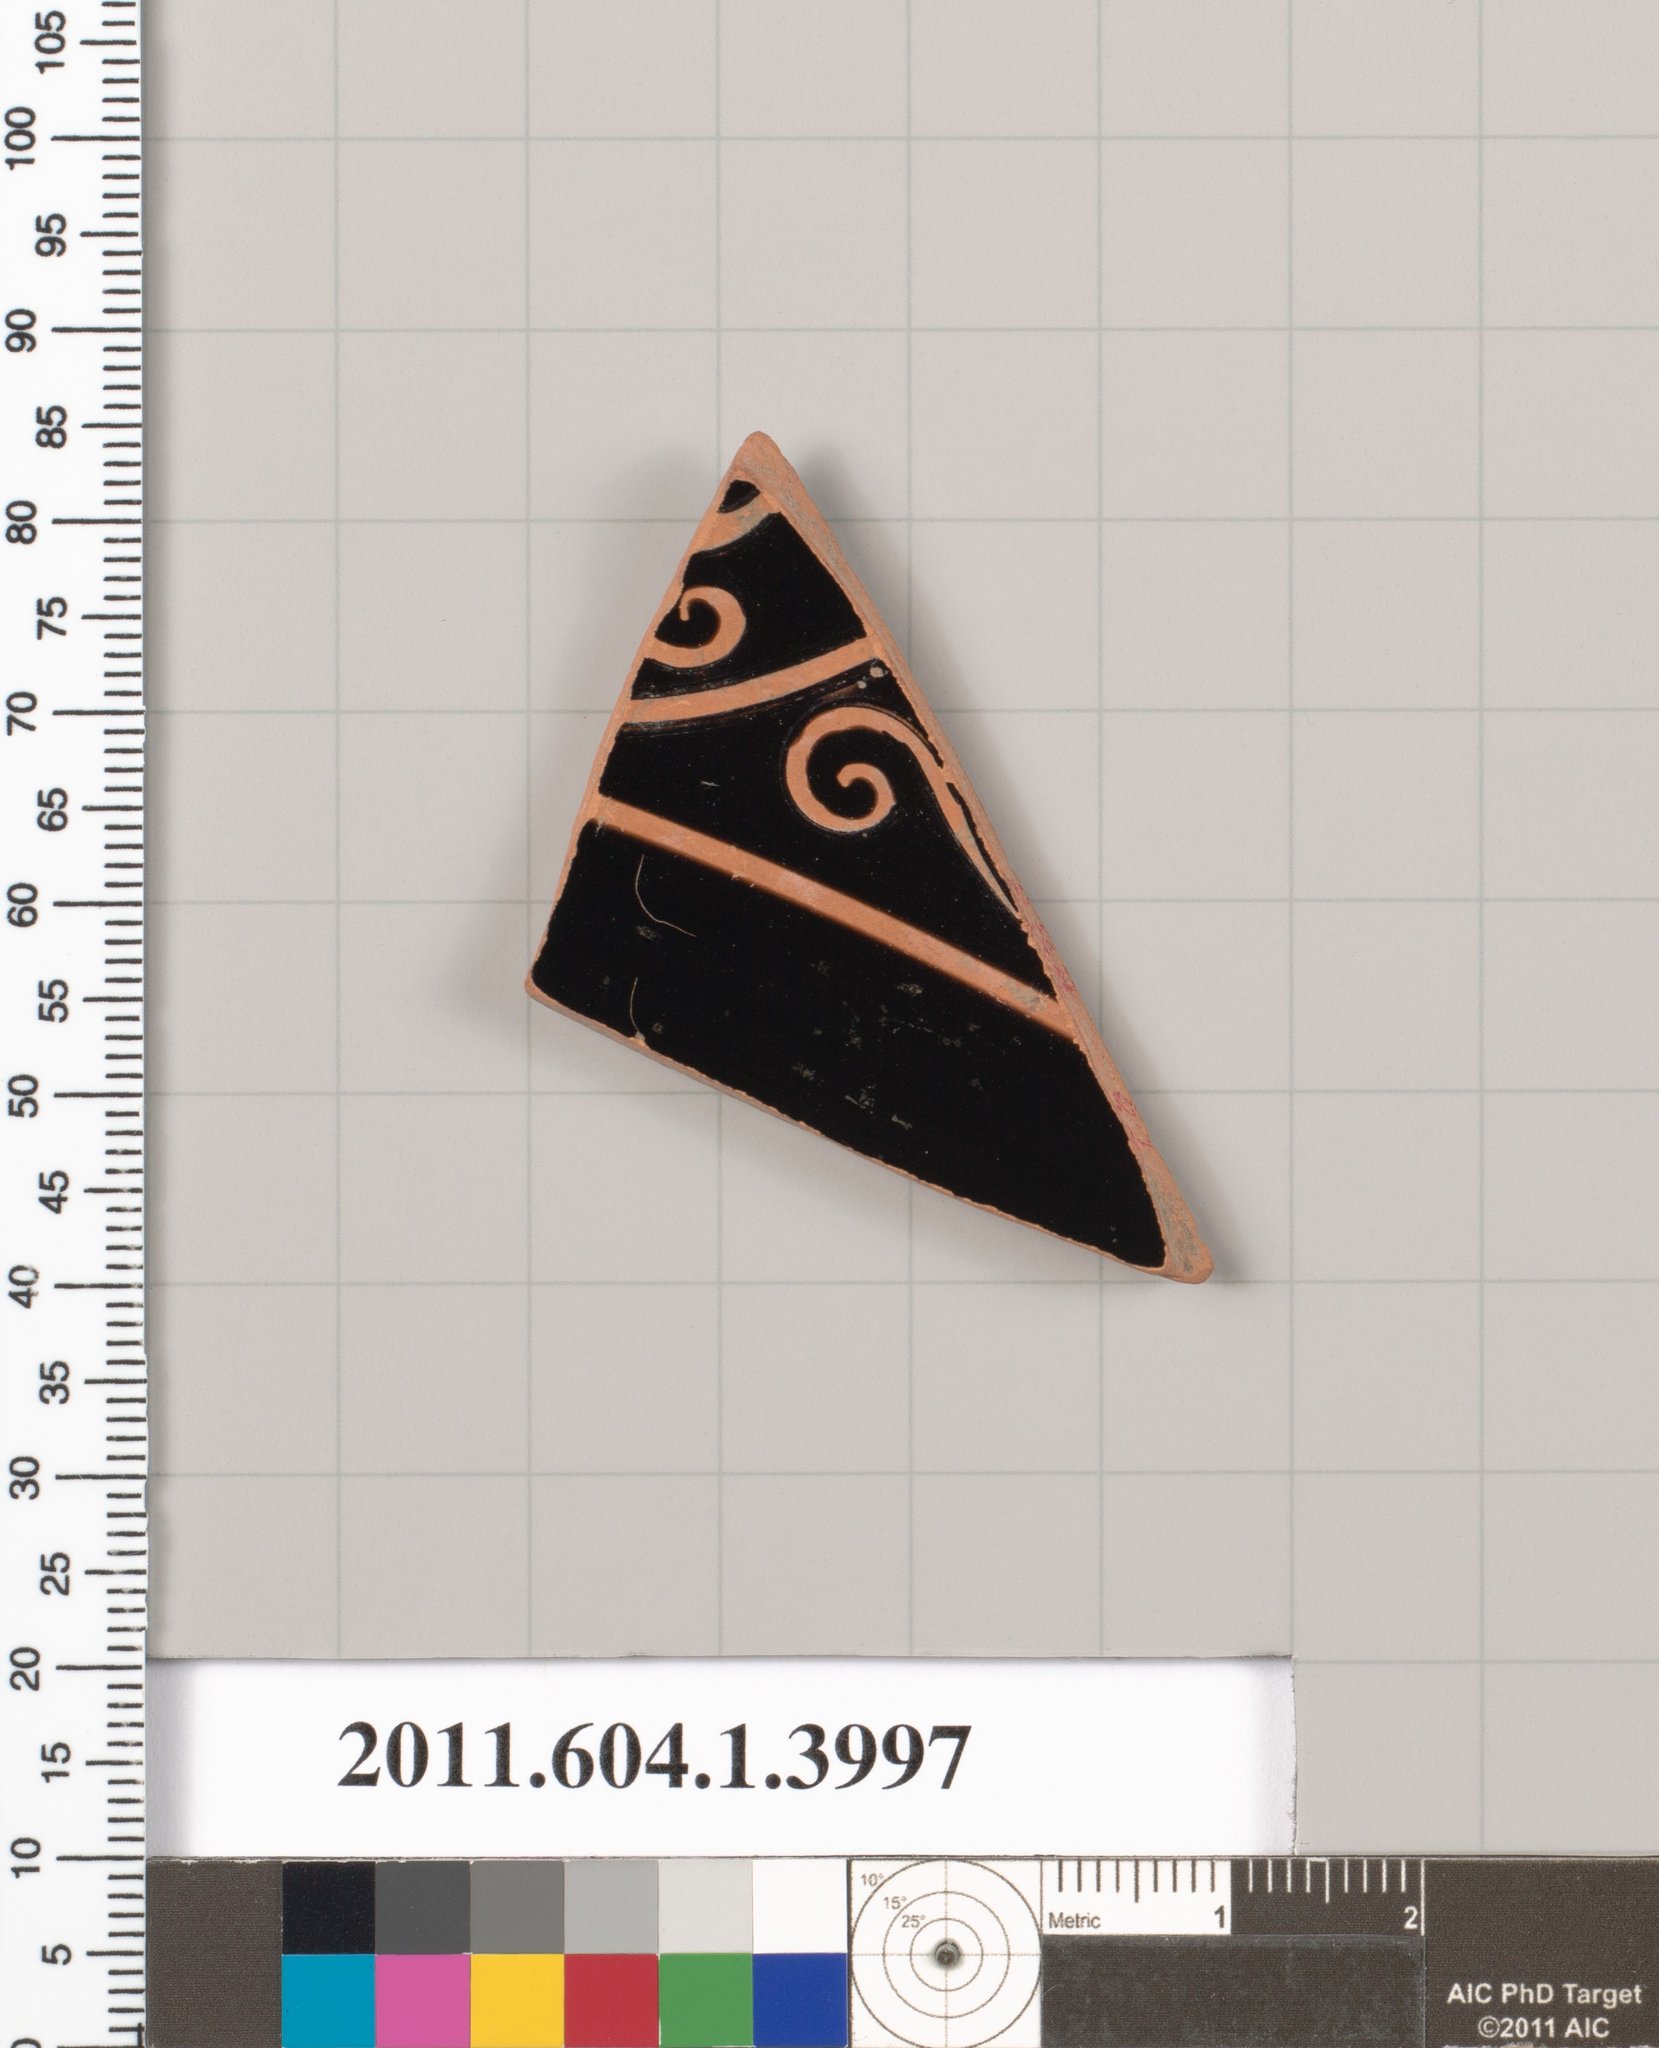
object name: kylix fragment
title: Terracotta fragment of a kylix (drinking cup)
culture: greek, attic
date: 510-490 BCE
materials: terracotta